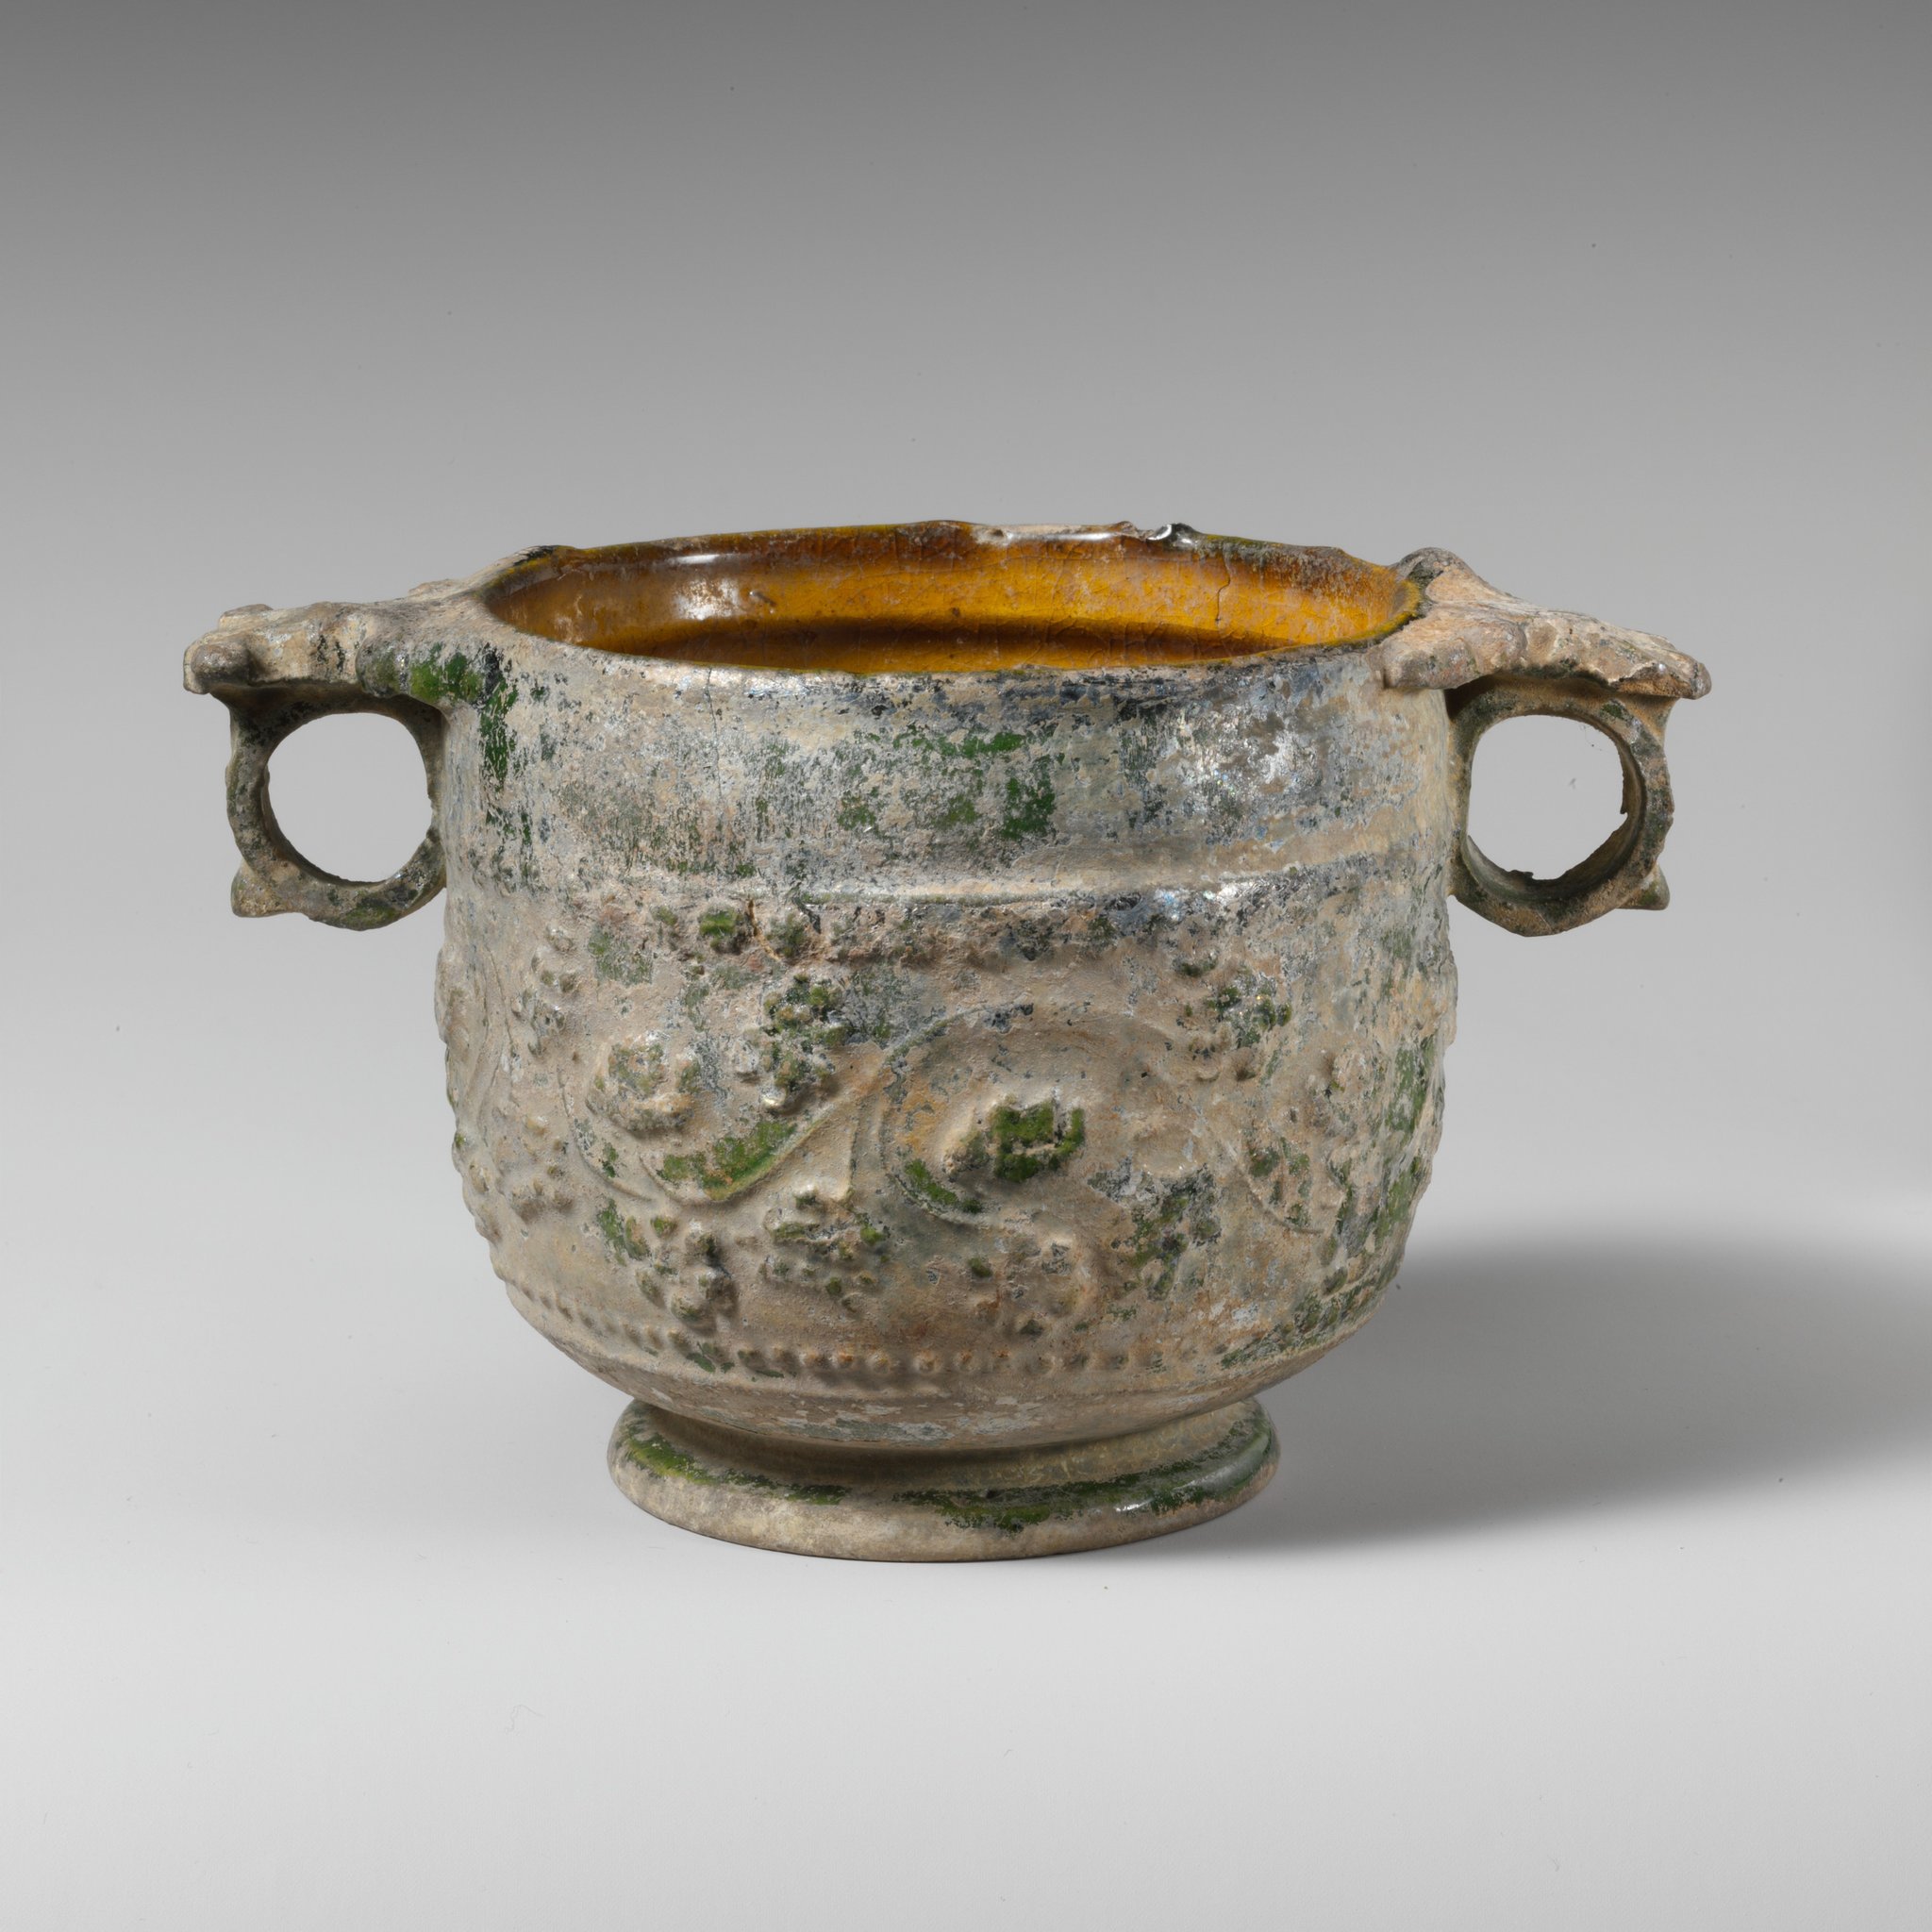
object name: skyphos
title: Terracotta scyphus (drinking cup)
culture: roman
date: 1-50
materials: terracotta